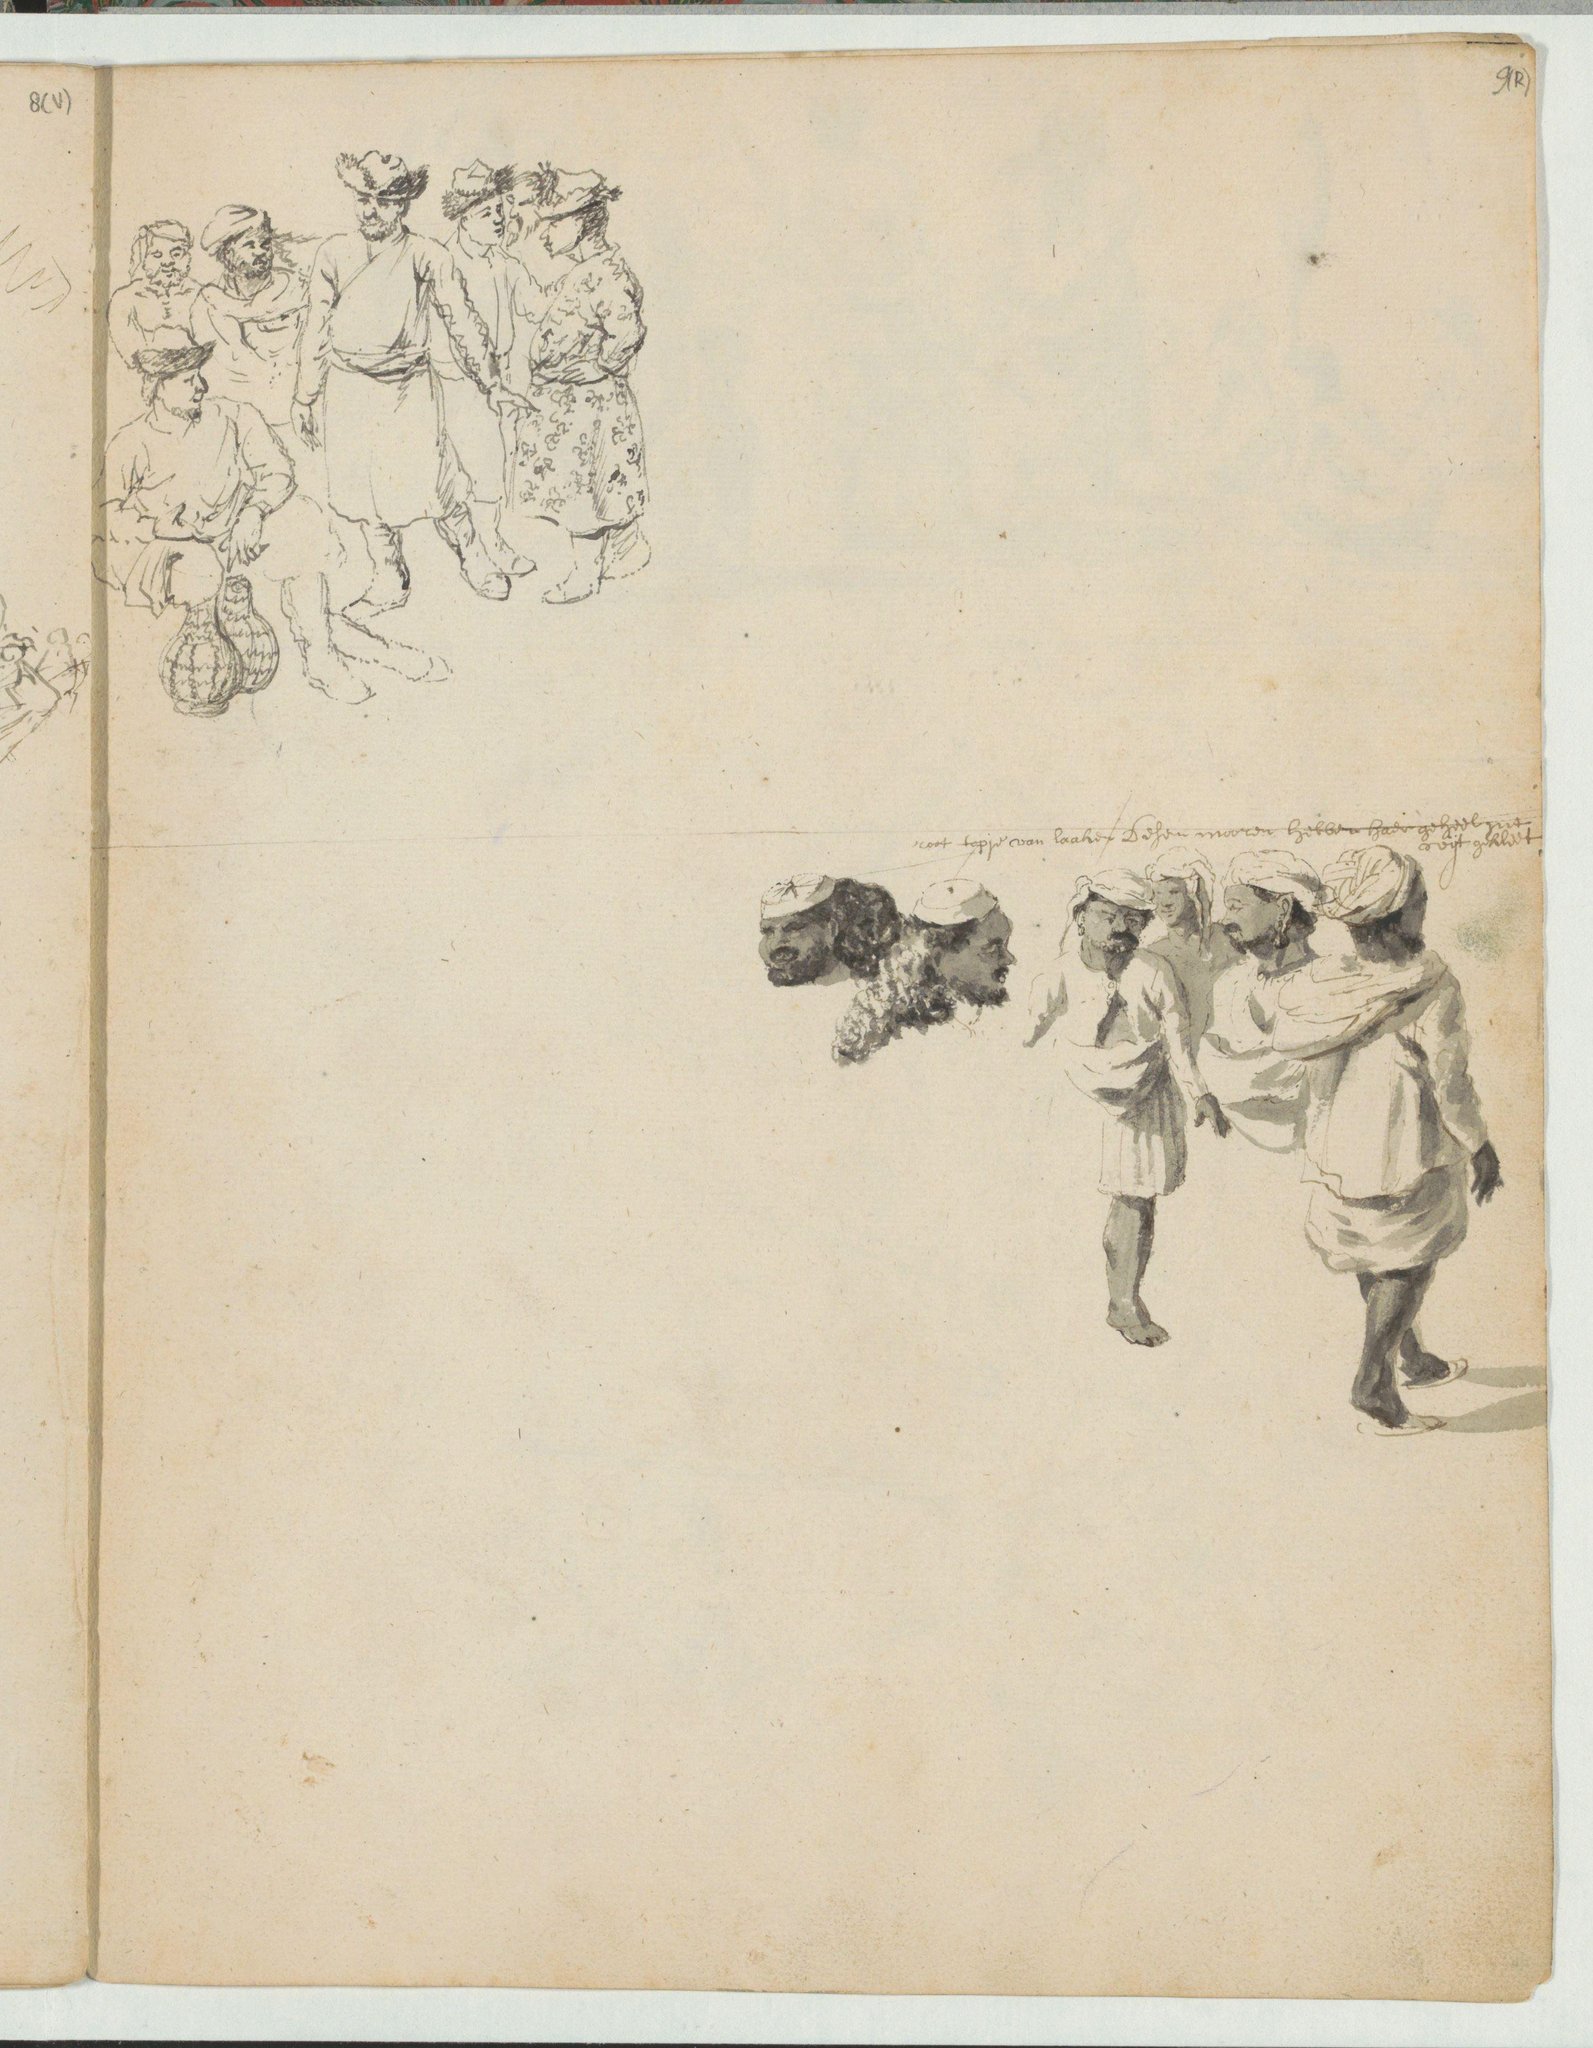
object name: sketchbook leaf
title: Groep mannen met hoeden en Mooren met tulbanden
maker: wouter schouten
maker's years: 1638-1704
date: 1660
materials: ink, paper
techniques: brush, pen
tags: head-gear: turban (+ men's clothes), folk costume, regional costume (+ men's clothes), head-gear: hat (+ men's clothes), asiatic races and peoples (with name)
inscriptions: annotation: ‘root topje laaken [...] mooren [...]’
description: Blad 9 recto van een katern van 10 bladen afkomstig uit een schetsboek.